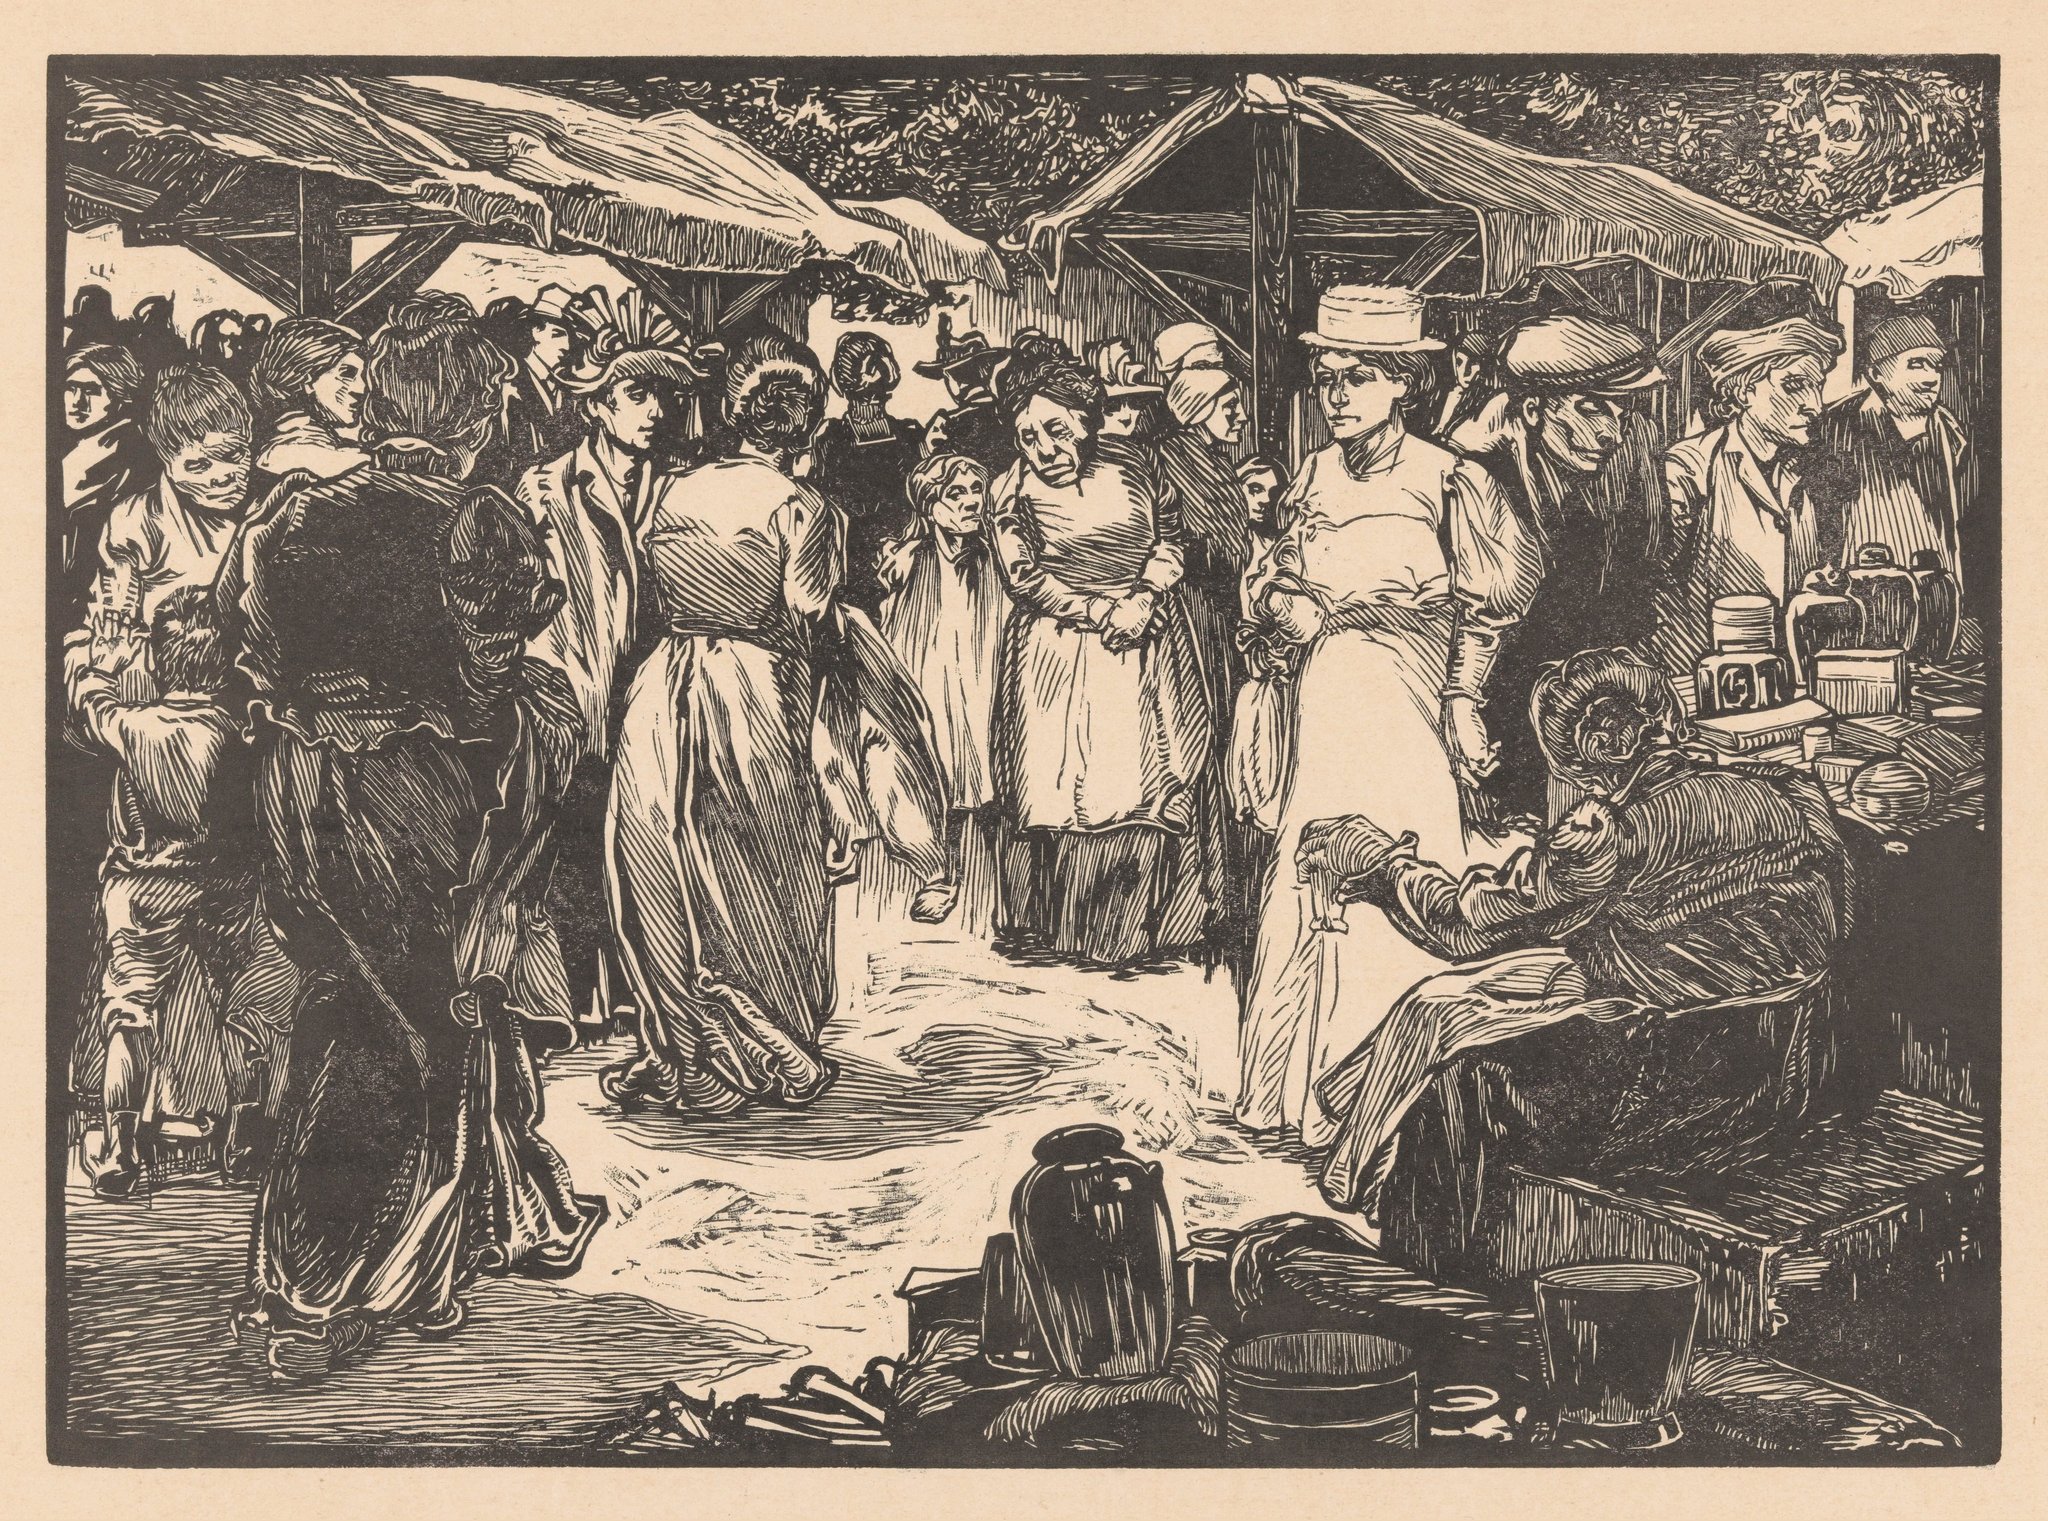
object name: print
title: Marktscène met mannen en vrouwen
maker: johannes josephus aarts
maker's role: draughtsman, print maker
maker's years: 1871-1934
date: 1881-1934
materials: paper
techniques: woodcut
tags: market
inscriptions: collector's mark: Lugt 2228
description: Rechts een marktkraam met uitgestalde waren. Boven de hoofden van de marktbezoekers de doeken van de marktkramen en het loof van bomen.